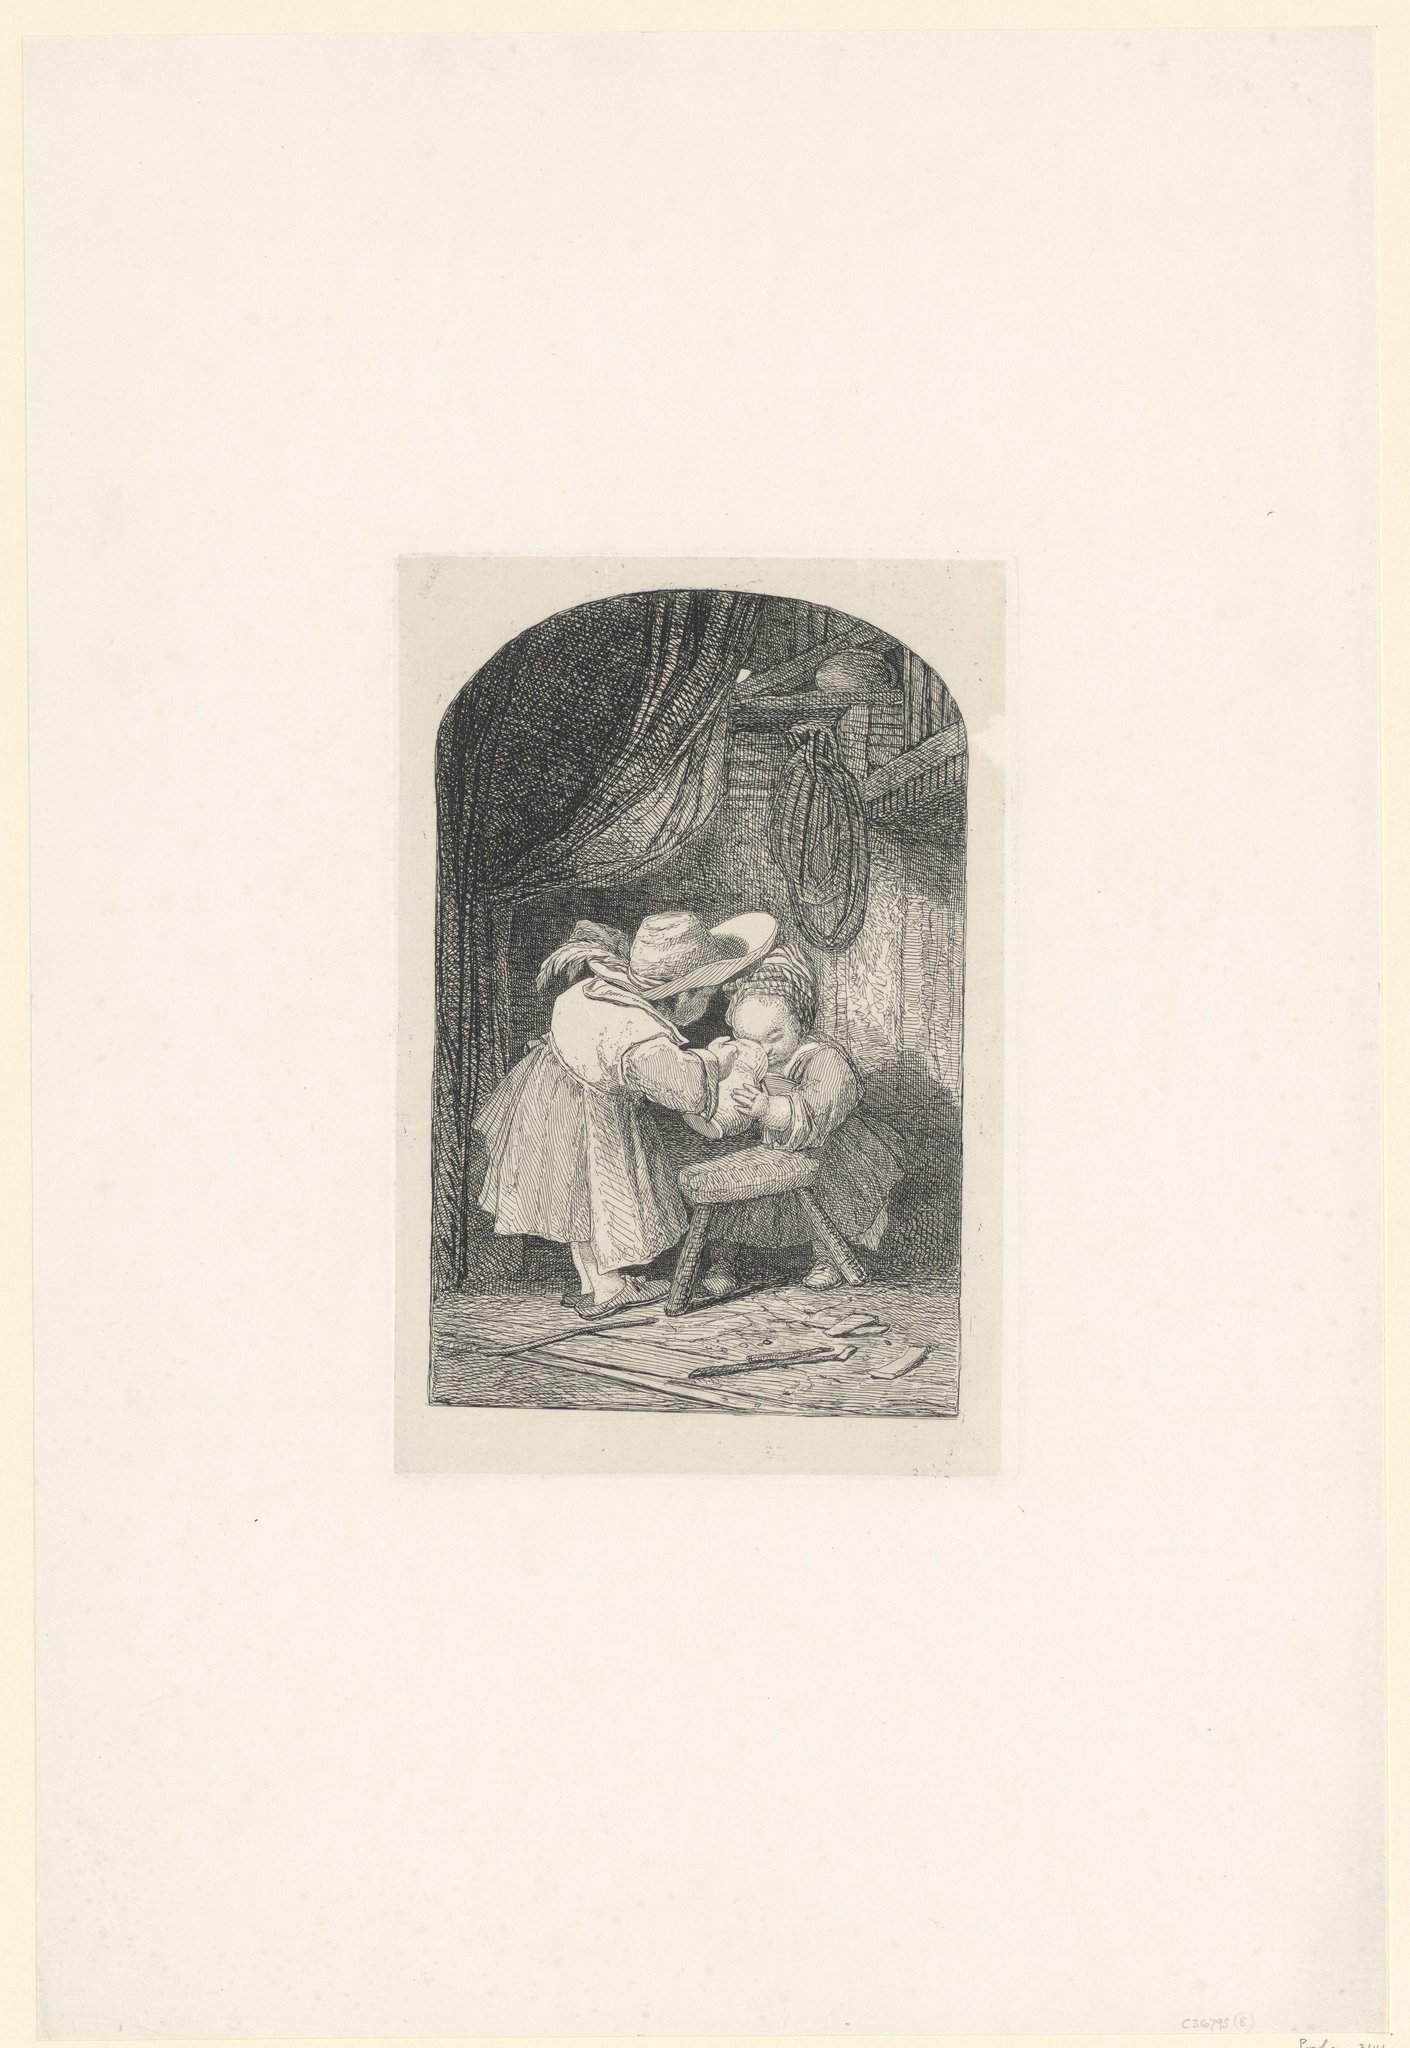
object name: print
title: Eight original etchings by the late John Sell Cotman, now first published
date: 1792-1842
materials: paper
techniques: etching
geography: norwich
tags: child, head-gear: hat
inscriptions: collector's mark: Lugt 2760, collector's mark: Lugt 2228